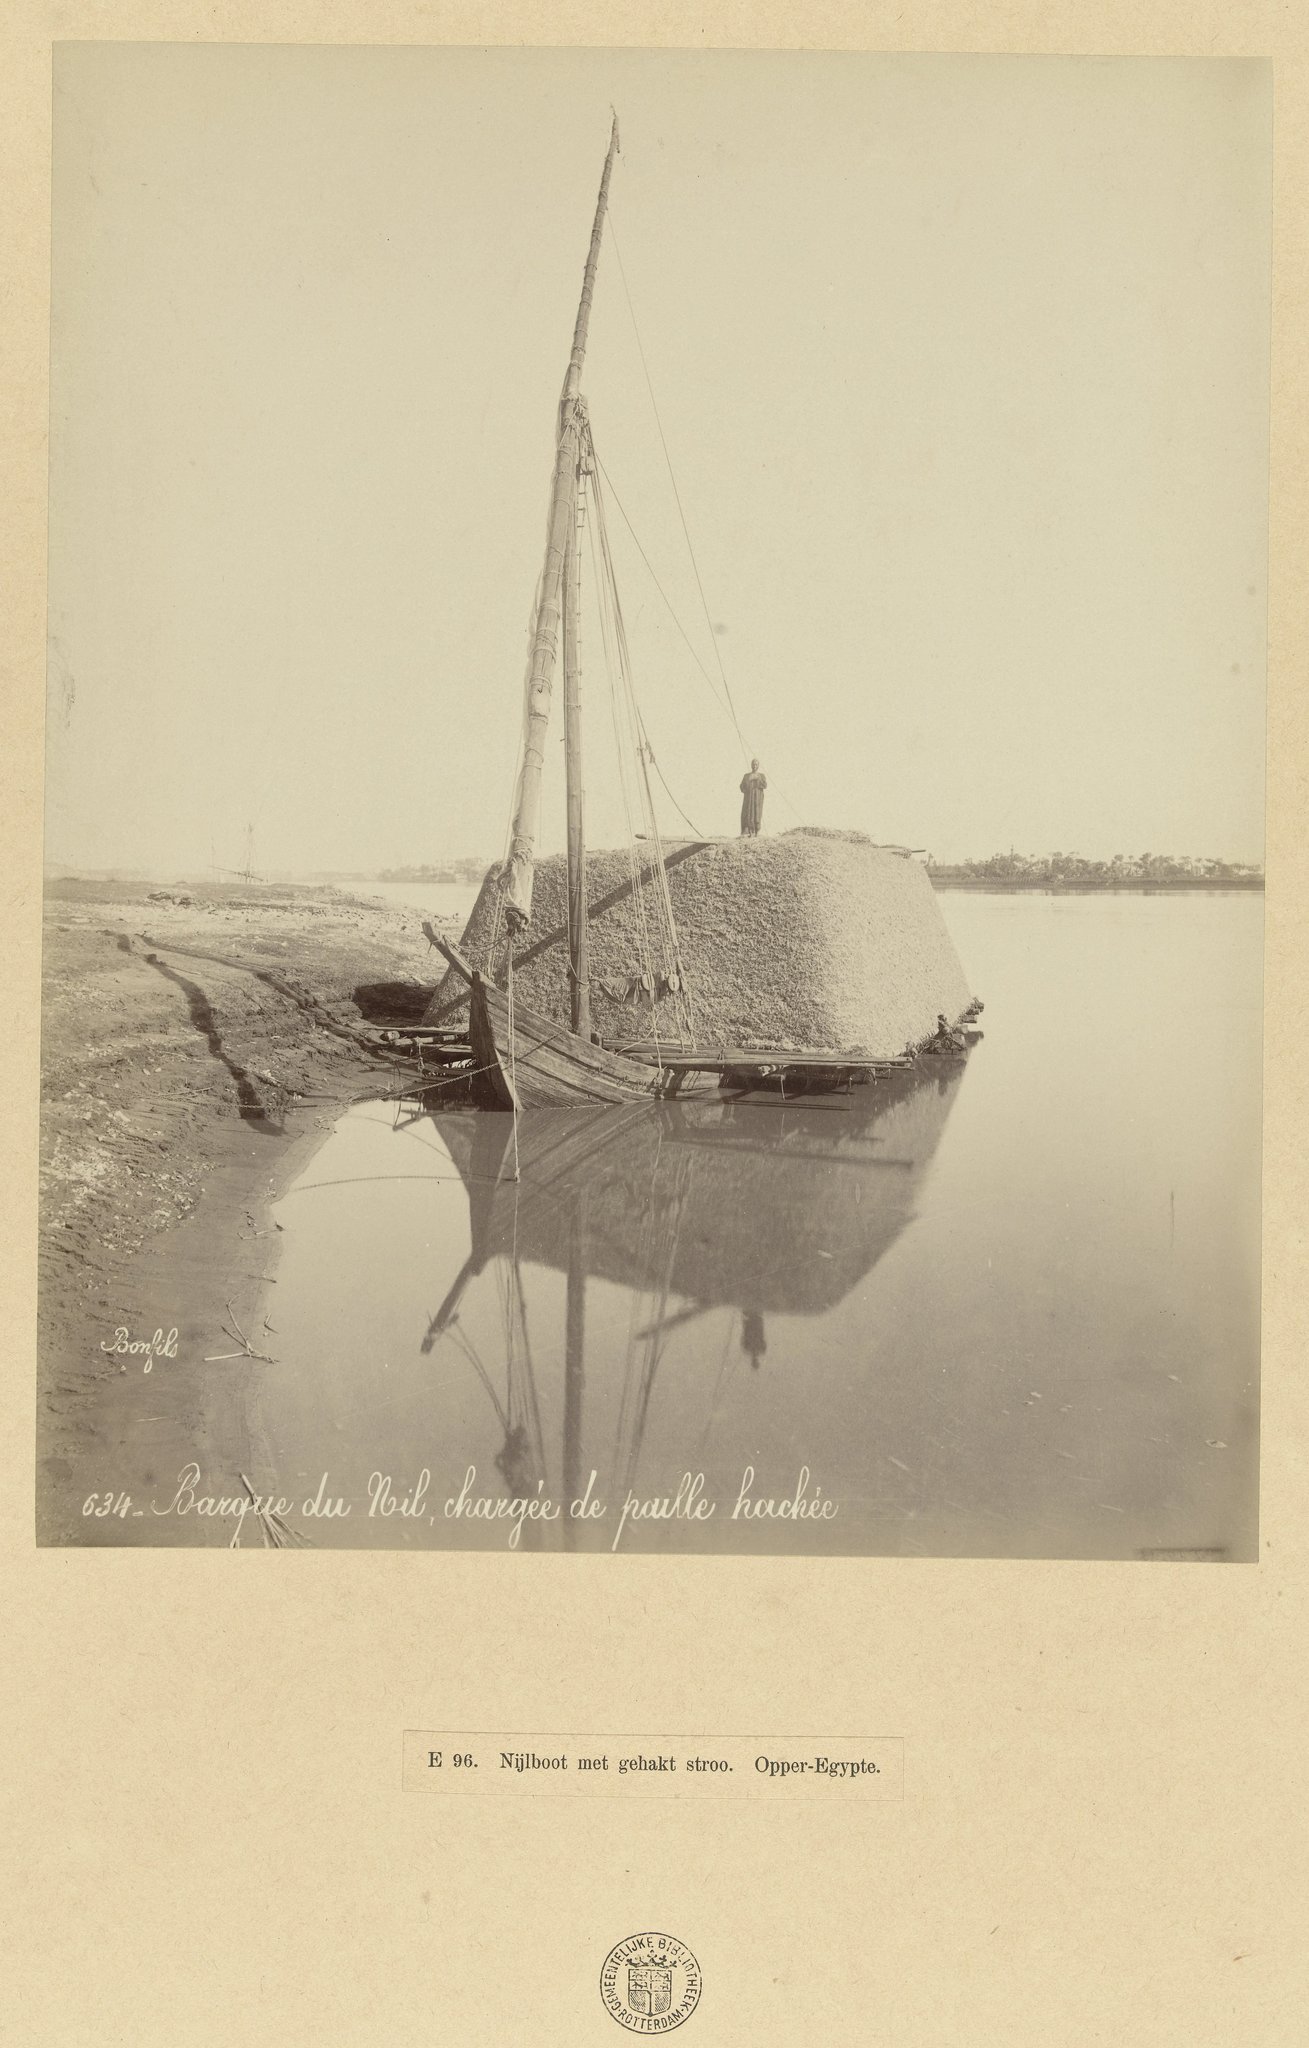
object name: photograph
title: E 96. Nijlboot met gehakt stroo. Opper-Egypte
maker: félix bonfils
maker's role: fotograaf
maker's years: 1831-1885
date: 1867-1885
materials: cardboard, paper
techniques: albumen print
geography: nile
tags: river, ships (in general)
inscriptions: check stamp: ‘Bristol/ L.M’, title: ‘E. 96. Nijlboot met gehakt stroo. Opper-Egypte.’, number: ‘634’, stamp: ‘GEMEENTELIJKE BIBLIOTHEEK/ ROTTERDAM’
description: Onderdeel van een groep door fotograaf Richard Polak op reis verzamelde foto’s. Deze foto is samen met andere op zijn reizen verzamelde foto's tentoongesteld bij de Rotterdamsche Kunstkring (1895), Arti en Amicitiae te Amsterdam (1897-1898?) en Societeit 't Collegie te Kampen (datum vooralsnog onbekend).